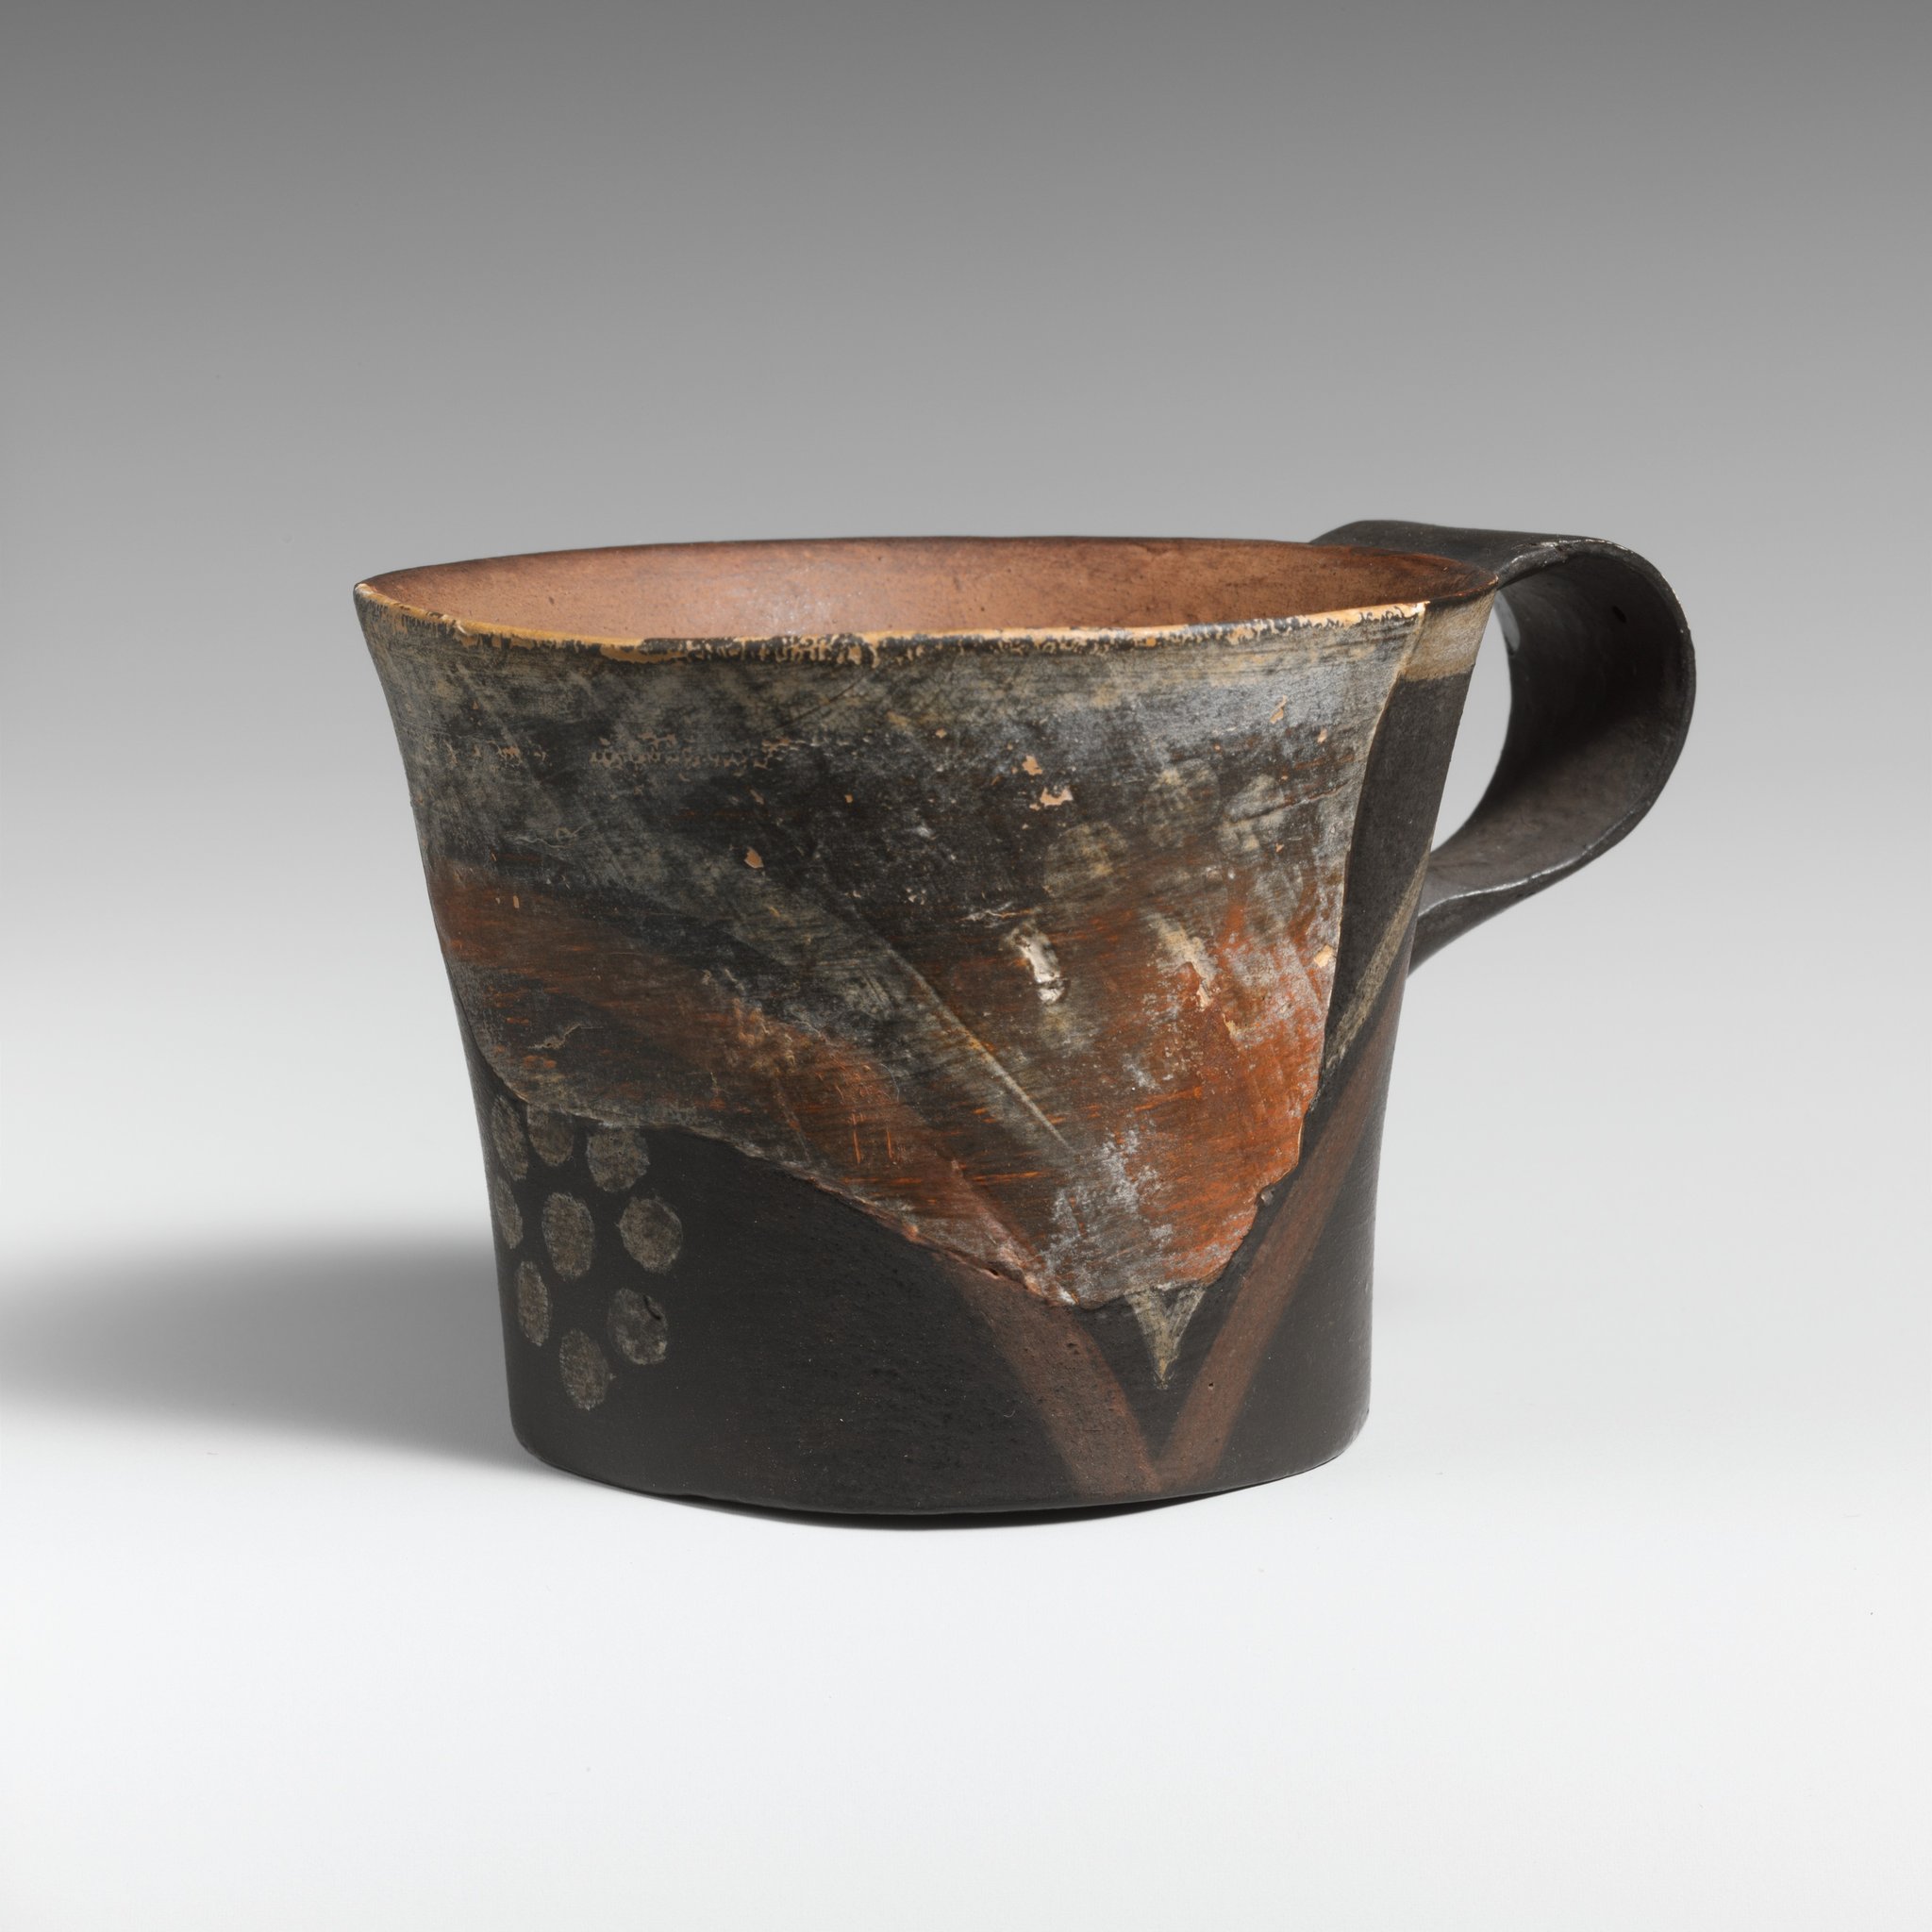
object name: cup, one handled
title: Terracotta straight-sided cup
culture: minoan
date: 1800-1700 BCE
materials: terracotta